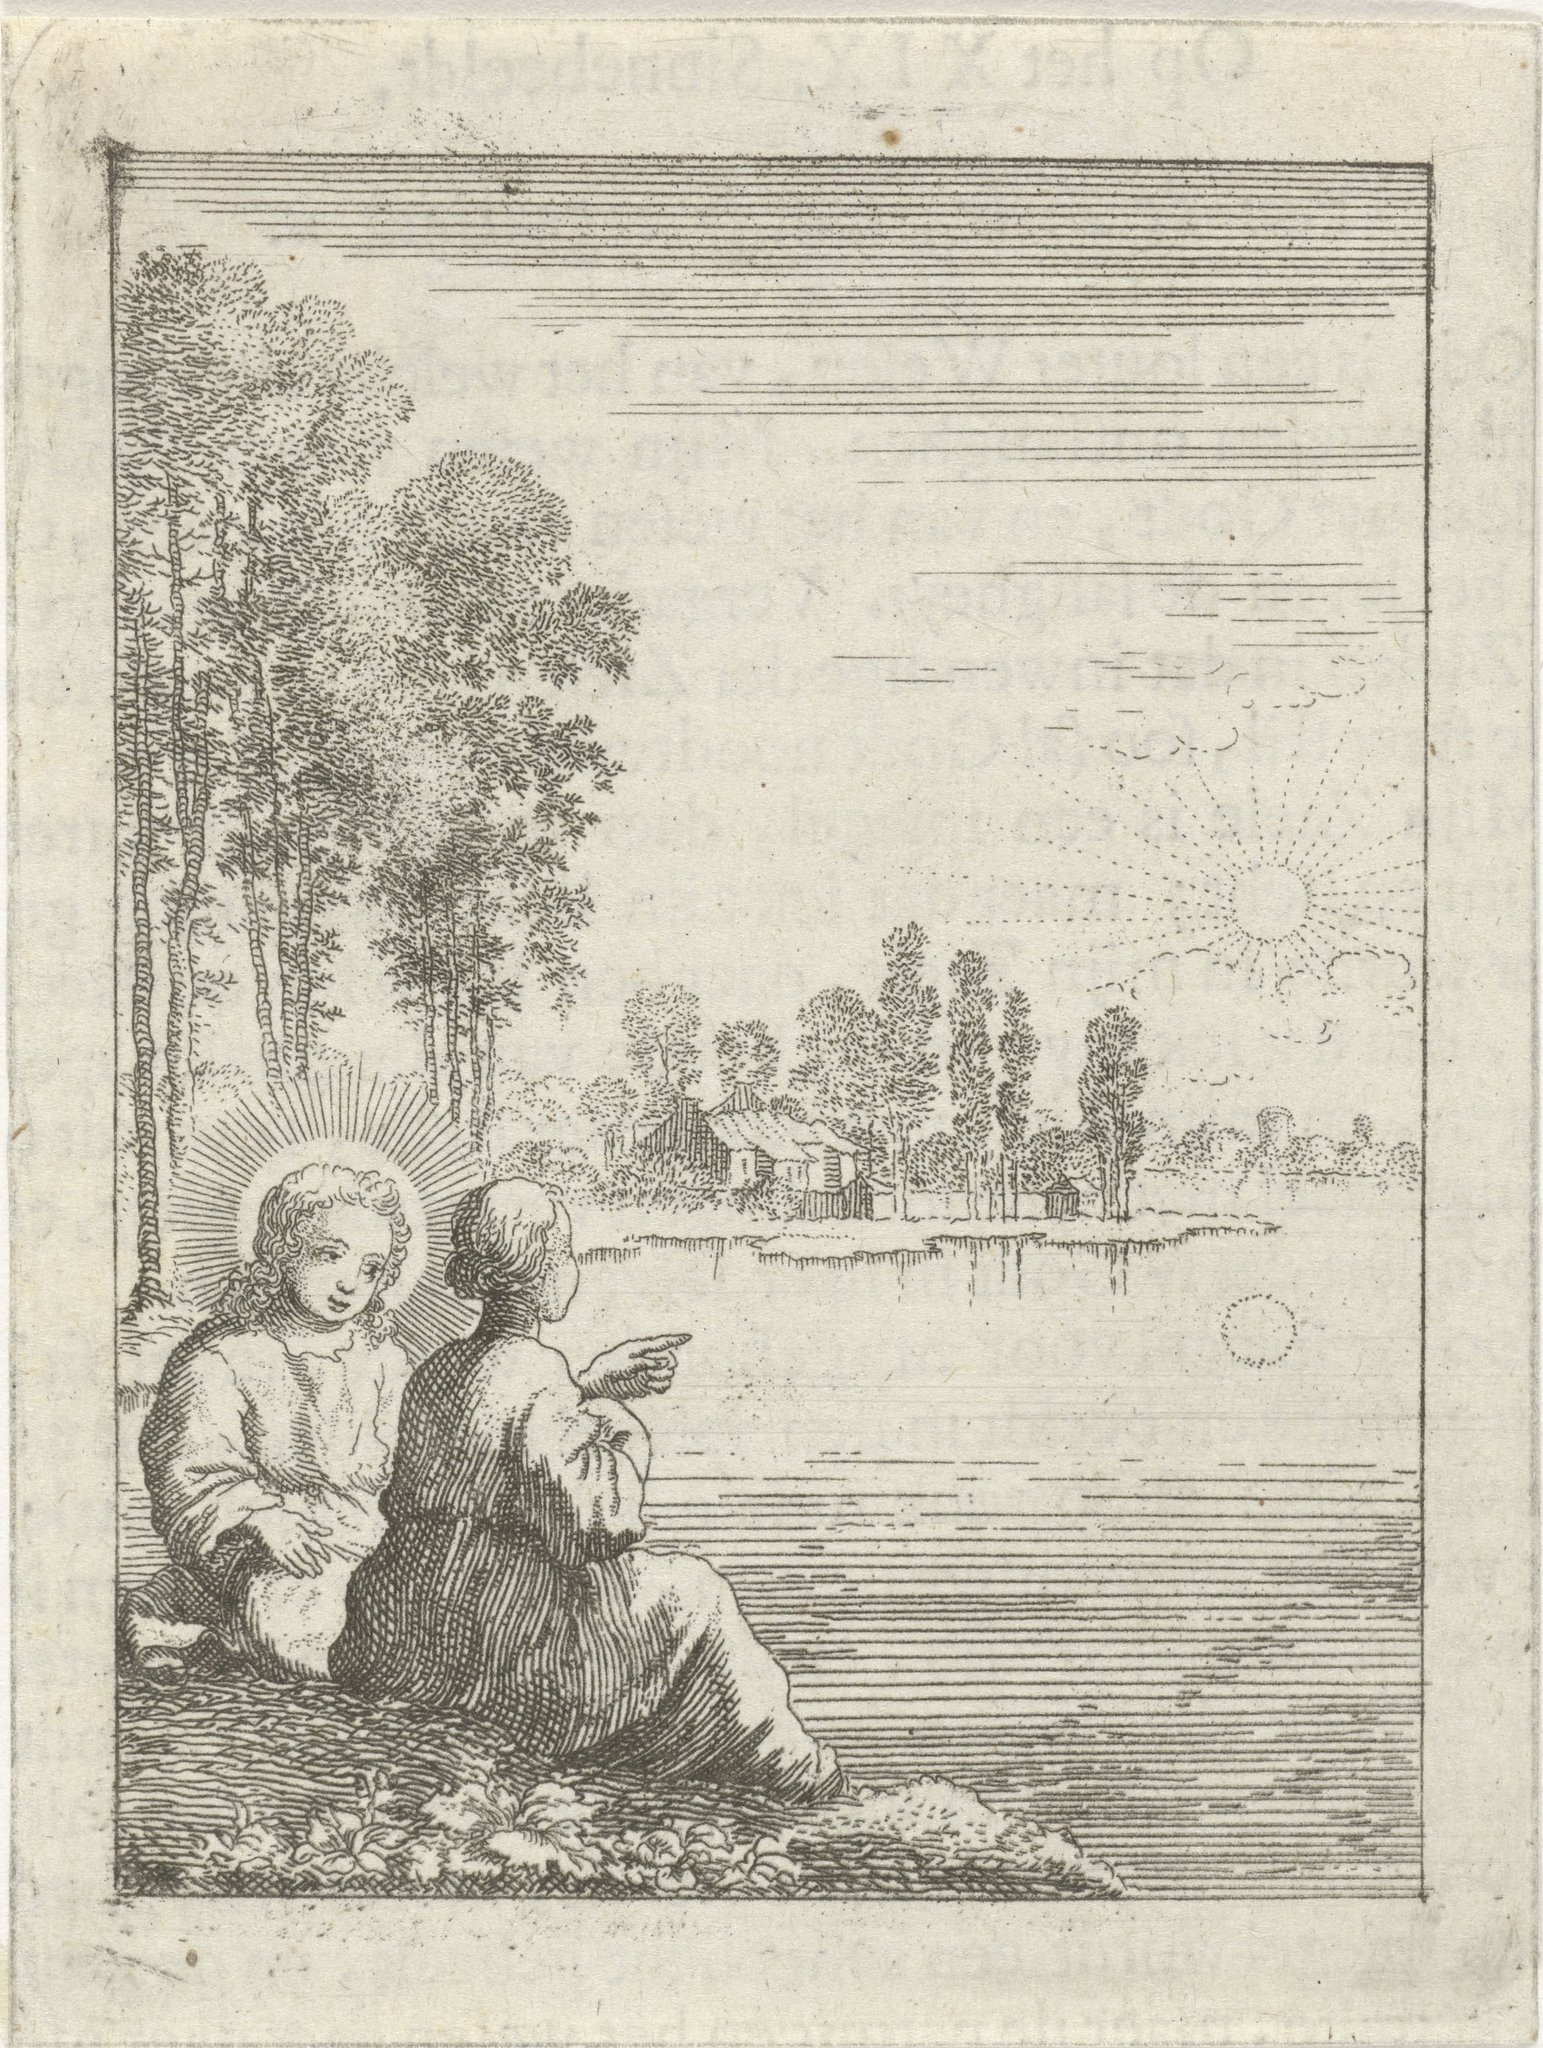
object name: book illustration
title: Christus en de gepersonifieerde ziel aanschouwen de zon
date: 1678-1687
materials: paper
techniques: etching, letterpress printing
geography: amsterdam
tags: sun as celestial body, christ and the soul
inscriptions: collector's mark: Lugt 2228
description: Illustratie uit: Luyken, Jan. Jezus en de Ziel, 3 delen. Amsterdam: Pieter Arentsz II, 1678-1687. Tussen 1678-1744 verschenen van dit emblemataboek 10 edities.